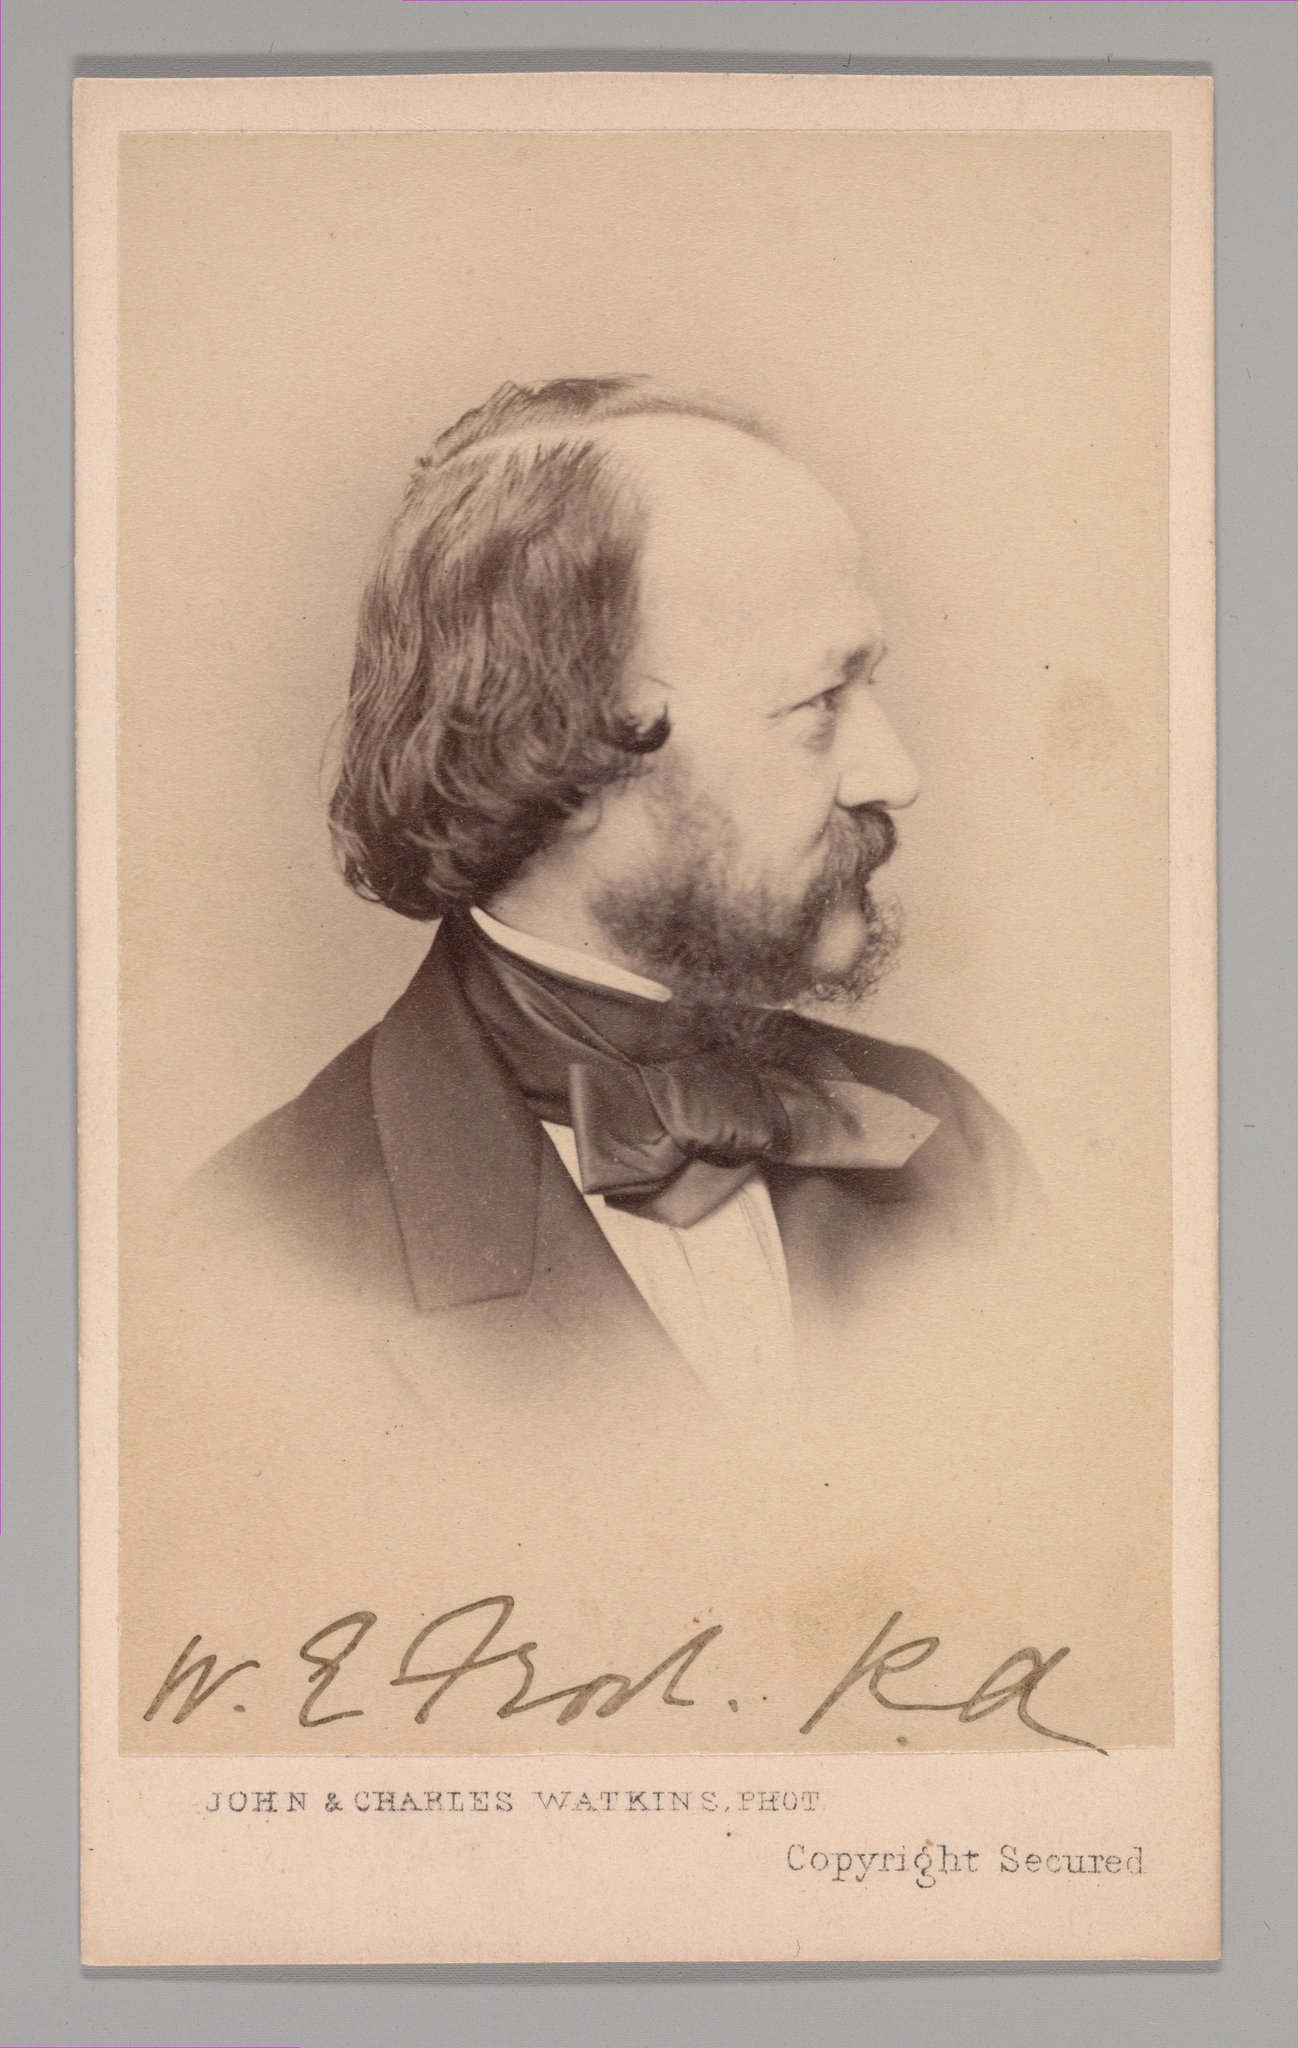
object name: carte de visite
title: [William Edward Frost]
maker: john and charles watkins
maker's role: photography studio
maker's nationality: british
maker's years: 1840-1875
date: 1860-1869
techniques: albumen silver print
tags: men,portraits,profiles